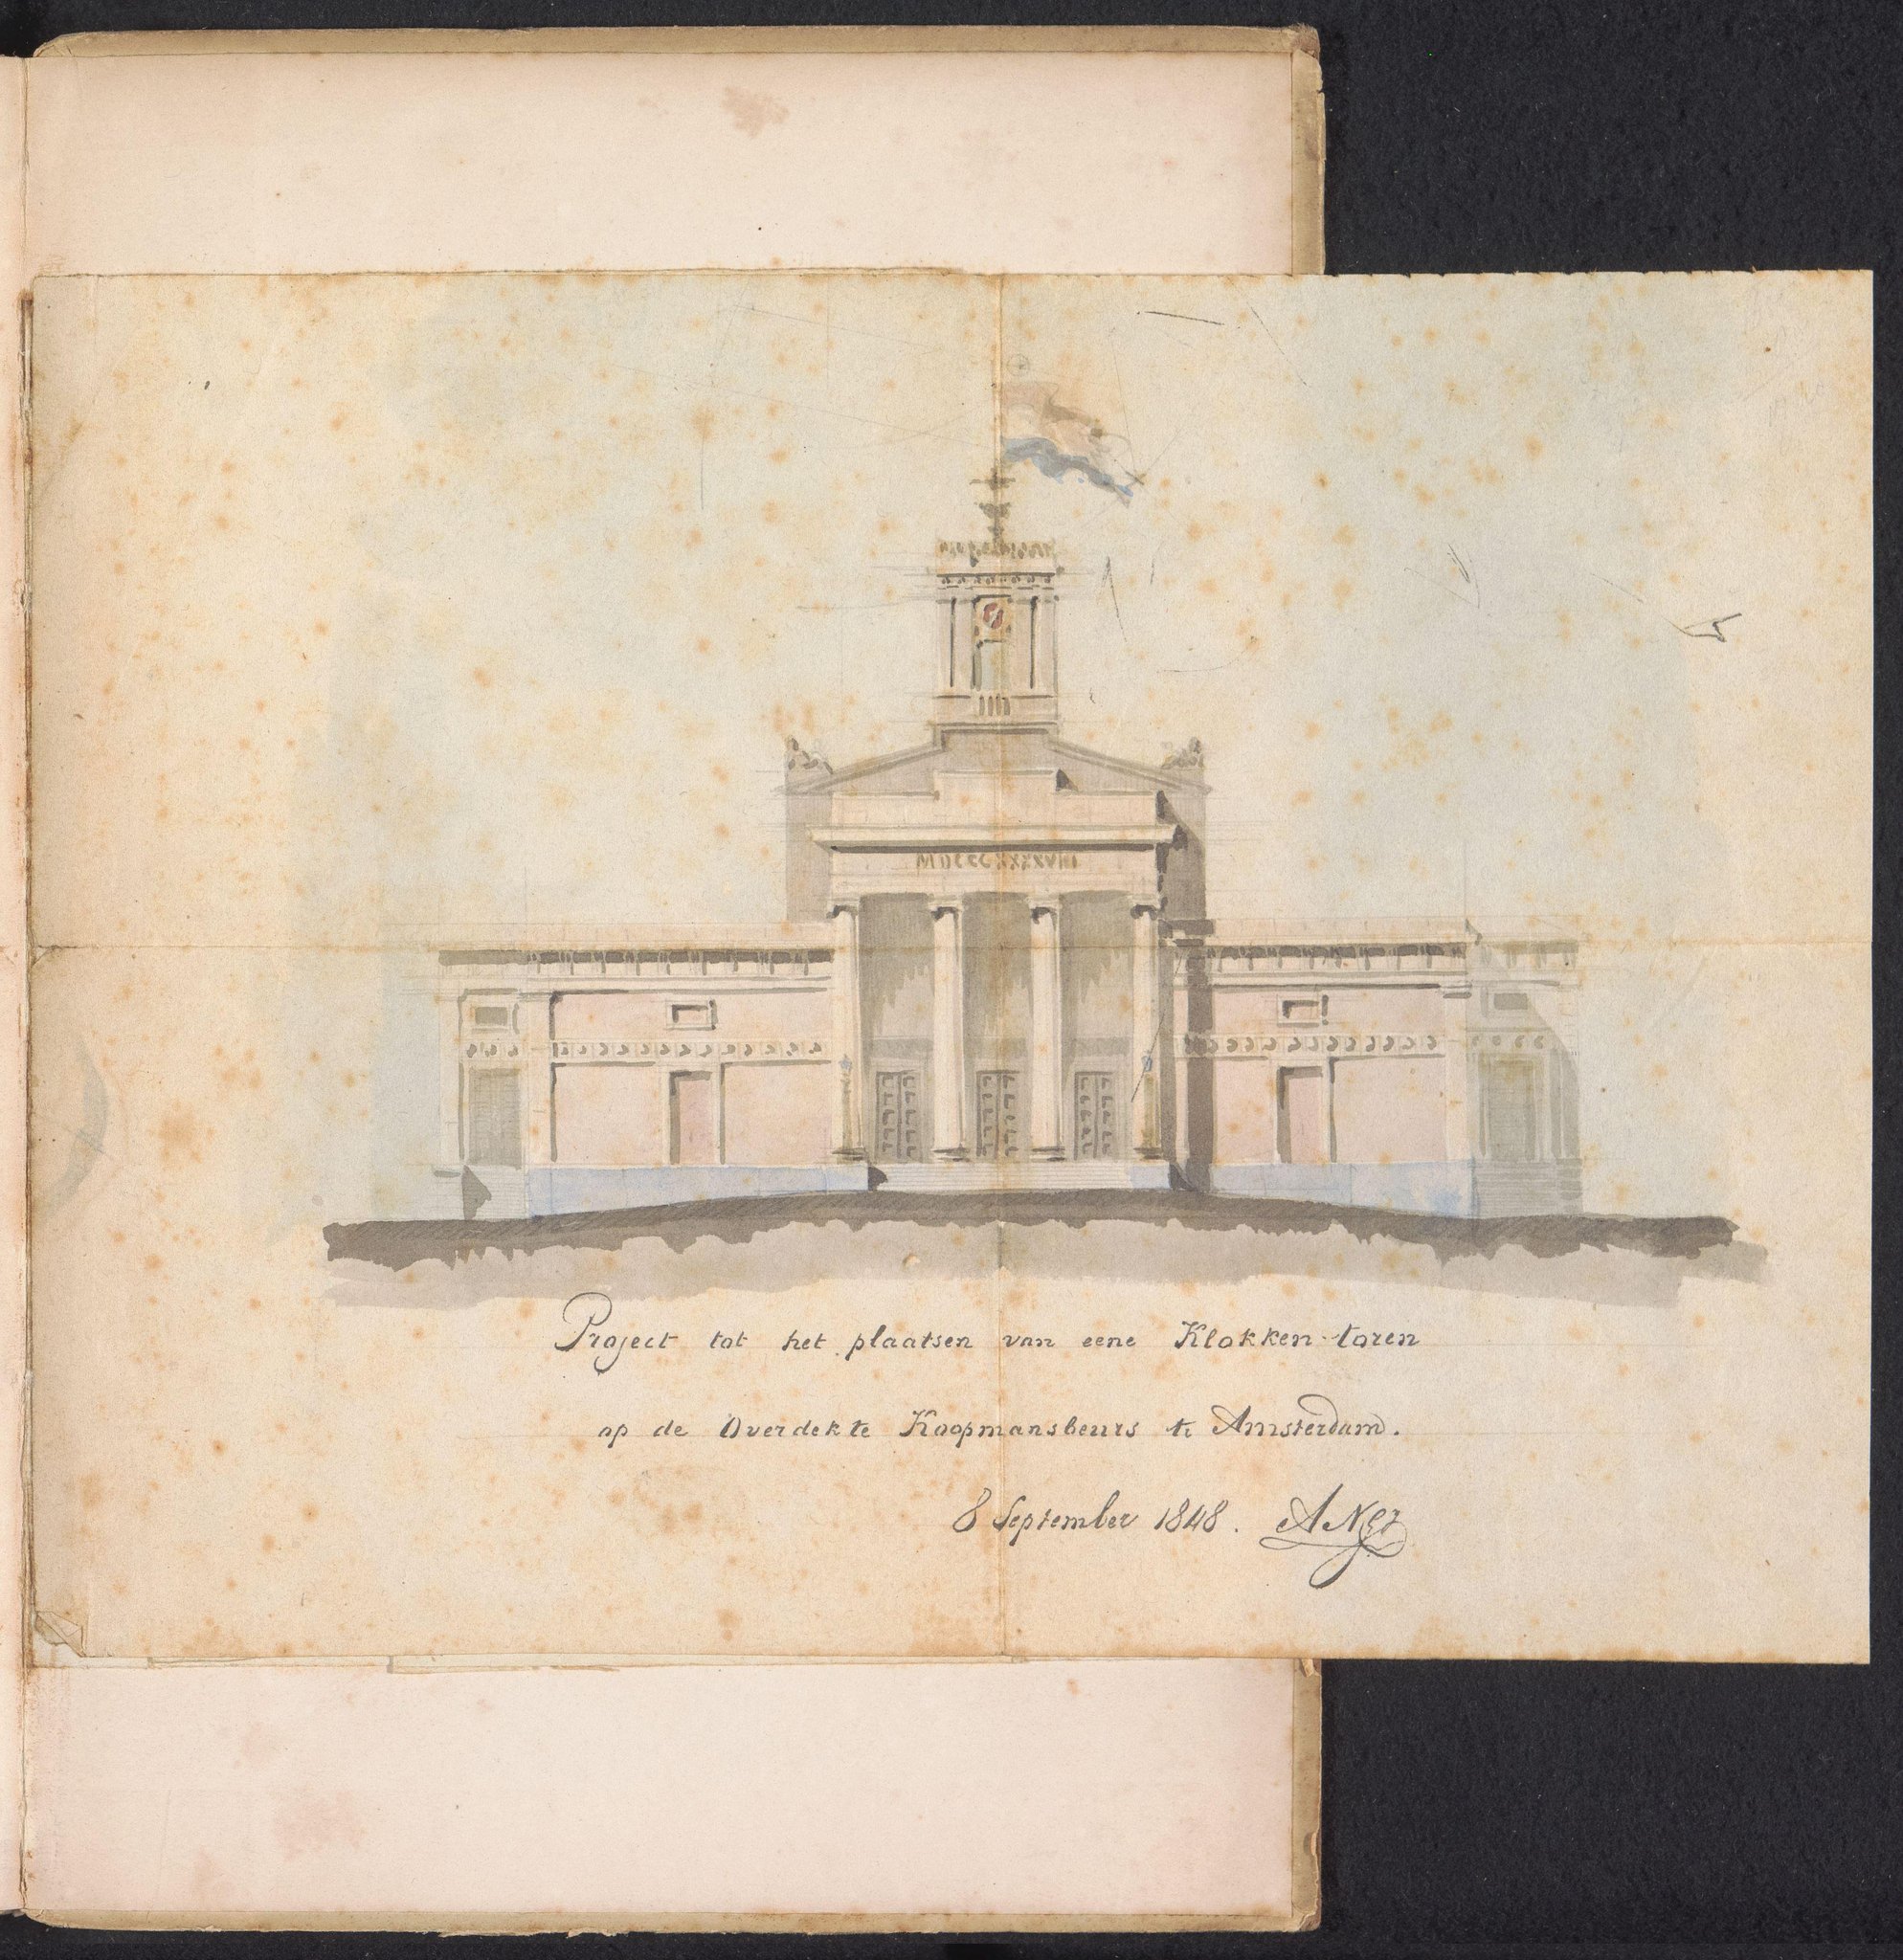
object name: drawing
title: Project tot het plaatsen van eene Klokken-toren op de overdekte Koopmansbeurs te Amsterdam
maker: monogrammist angj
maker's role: draughtsman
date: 1848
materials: paper, pencil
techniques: brush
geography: amsterdam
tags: stock exchange, stock-market, architectural design or model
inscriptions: date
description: Ontwerp voor een klokkentoren op de nieuwe beurs van Zocher te Amsterdam, 1848. Vooraanzicht. Getekende illustratie ingeplakt in een boek uit 1846 over de oude en nieuwe beurs van Amsterdam.